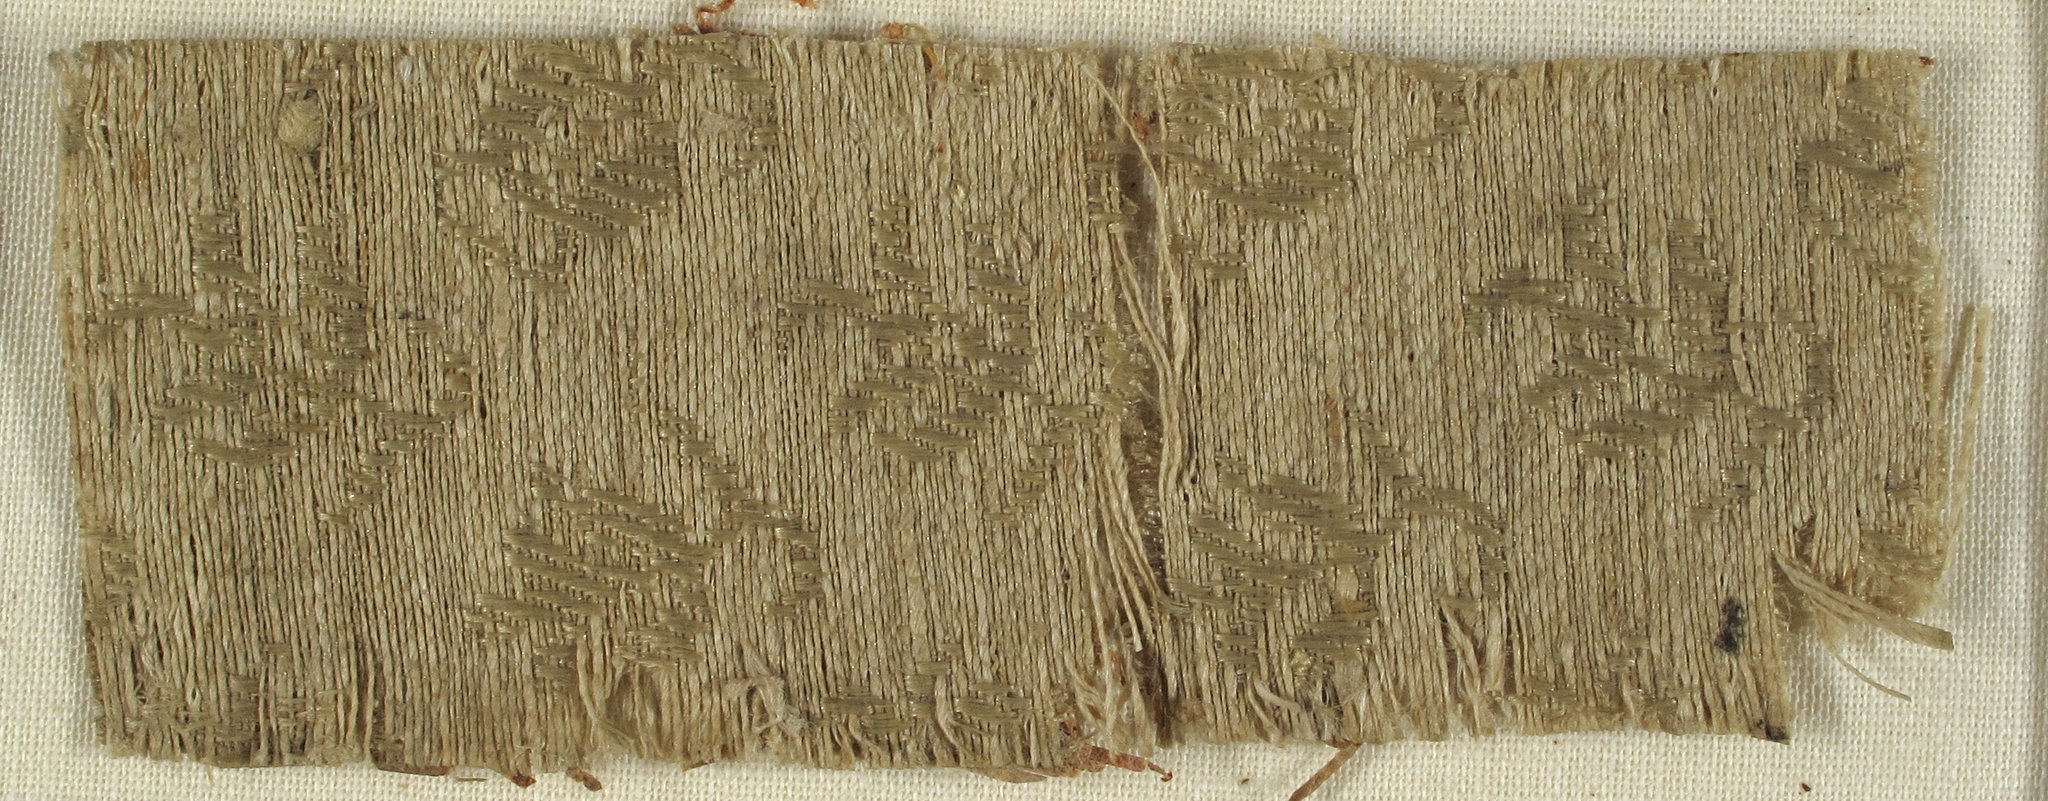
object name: textile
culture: german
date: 1501-1600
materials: linen